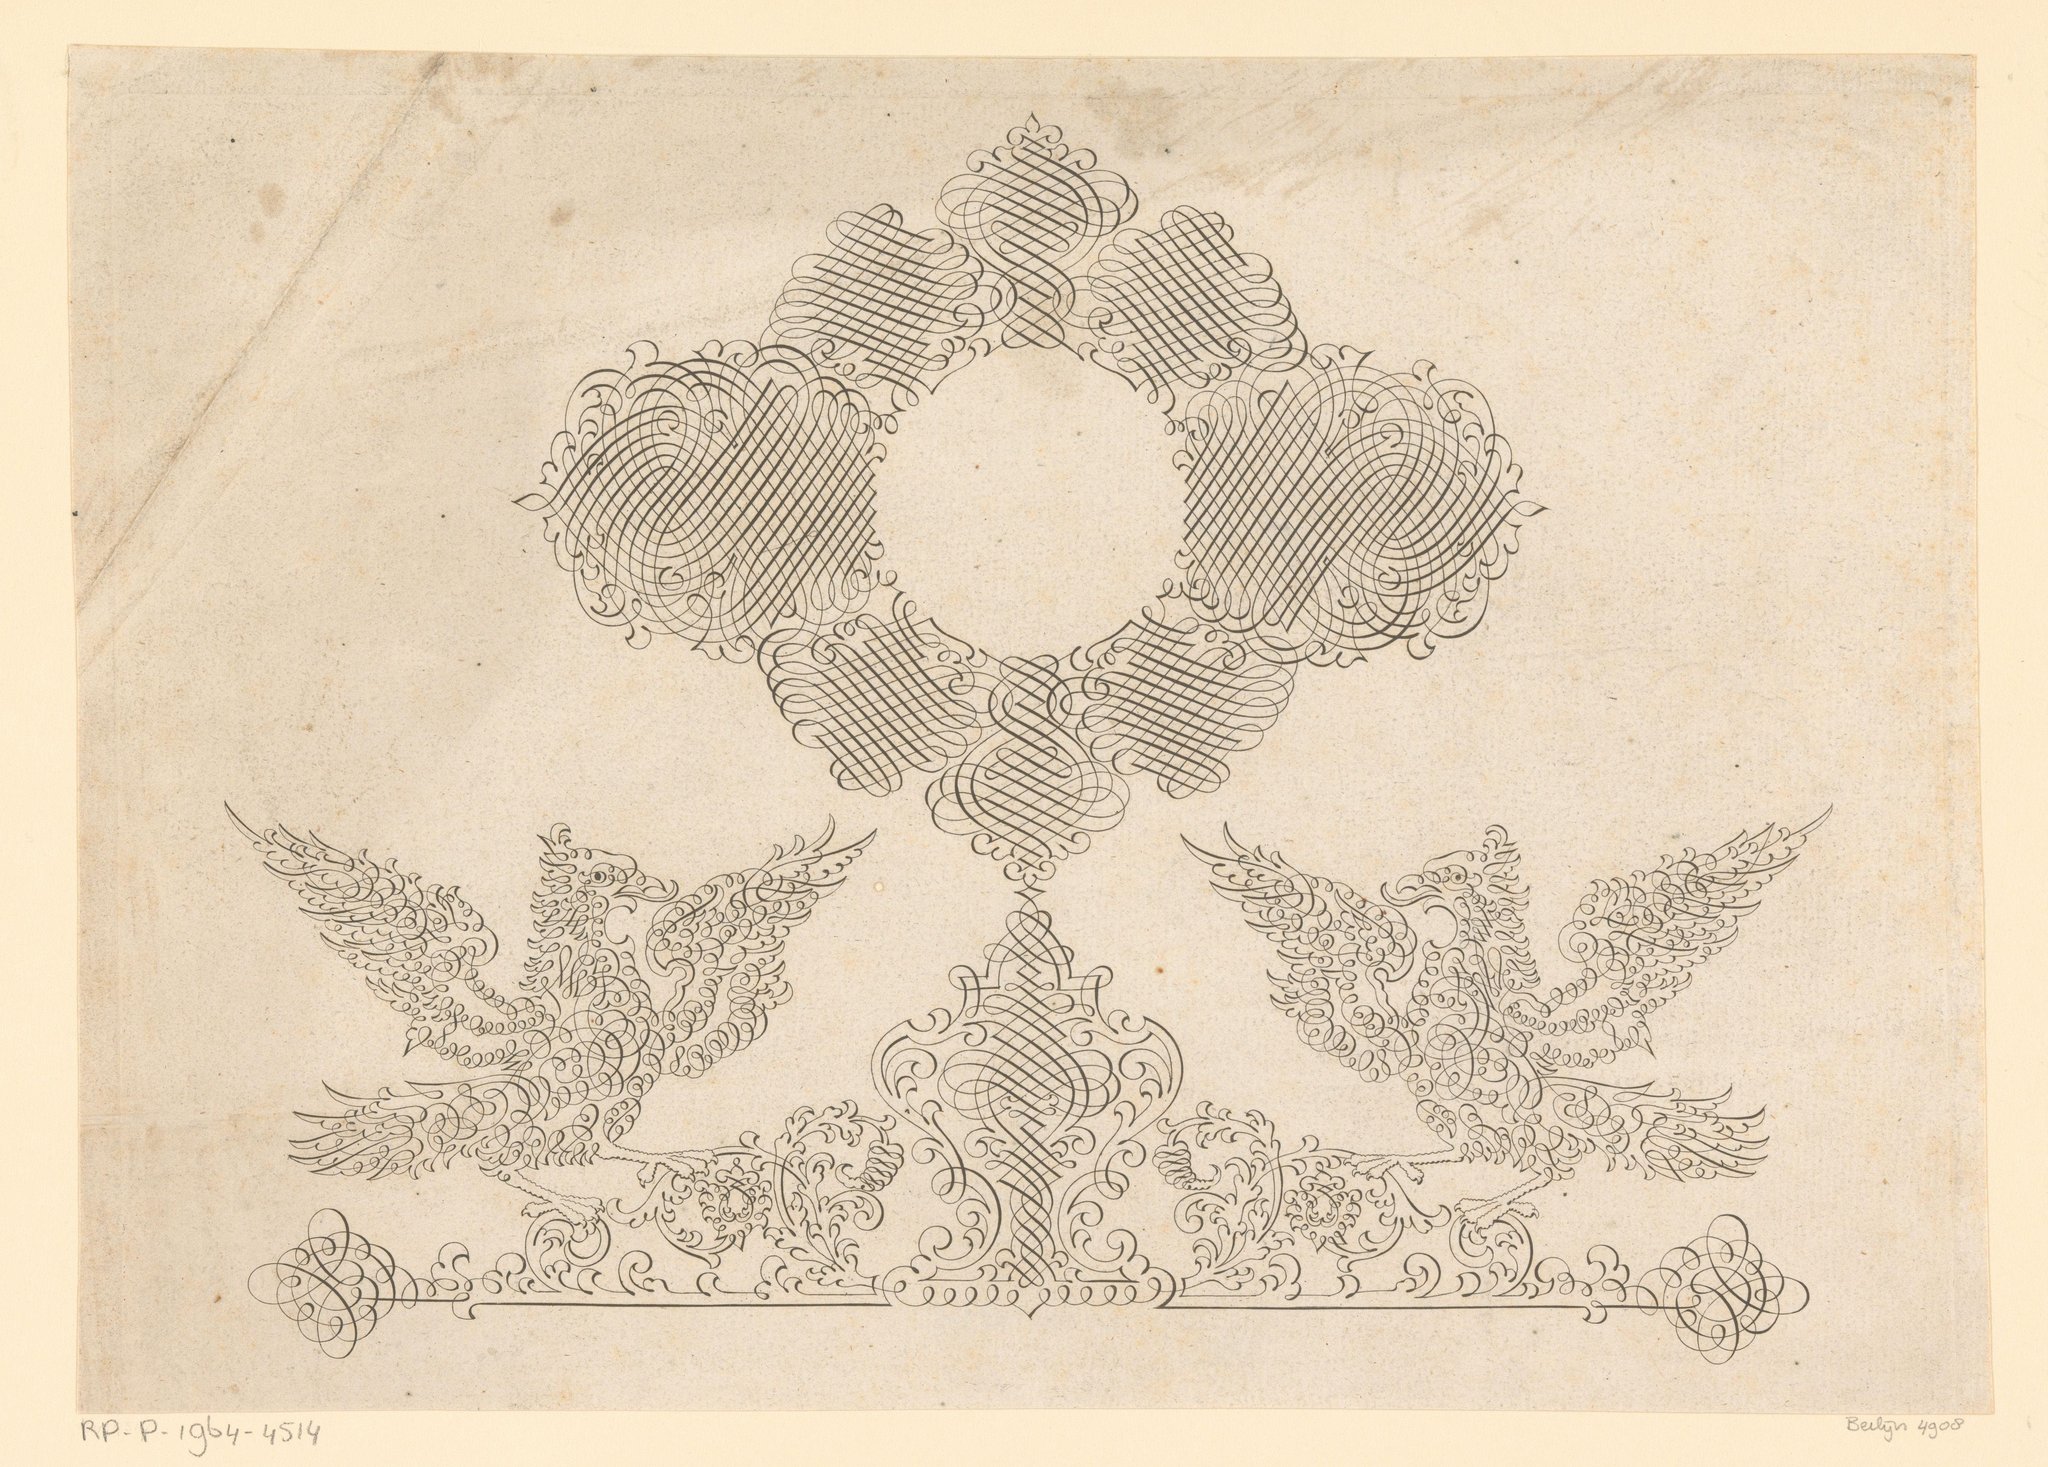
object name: ornament print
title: Vlechtwerk en vogels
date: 1756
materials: paper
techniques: engraving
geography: vienna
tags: birds, interlace ~ ornament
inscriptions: collector's mark: Lugt 2228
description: Rond ornament van vlechtwerk met aan weerszijden een vogel.